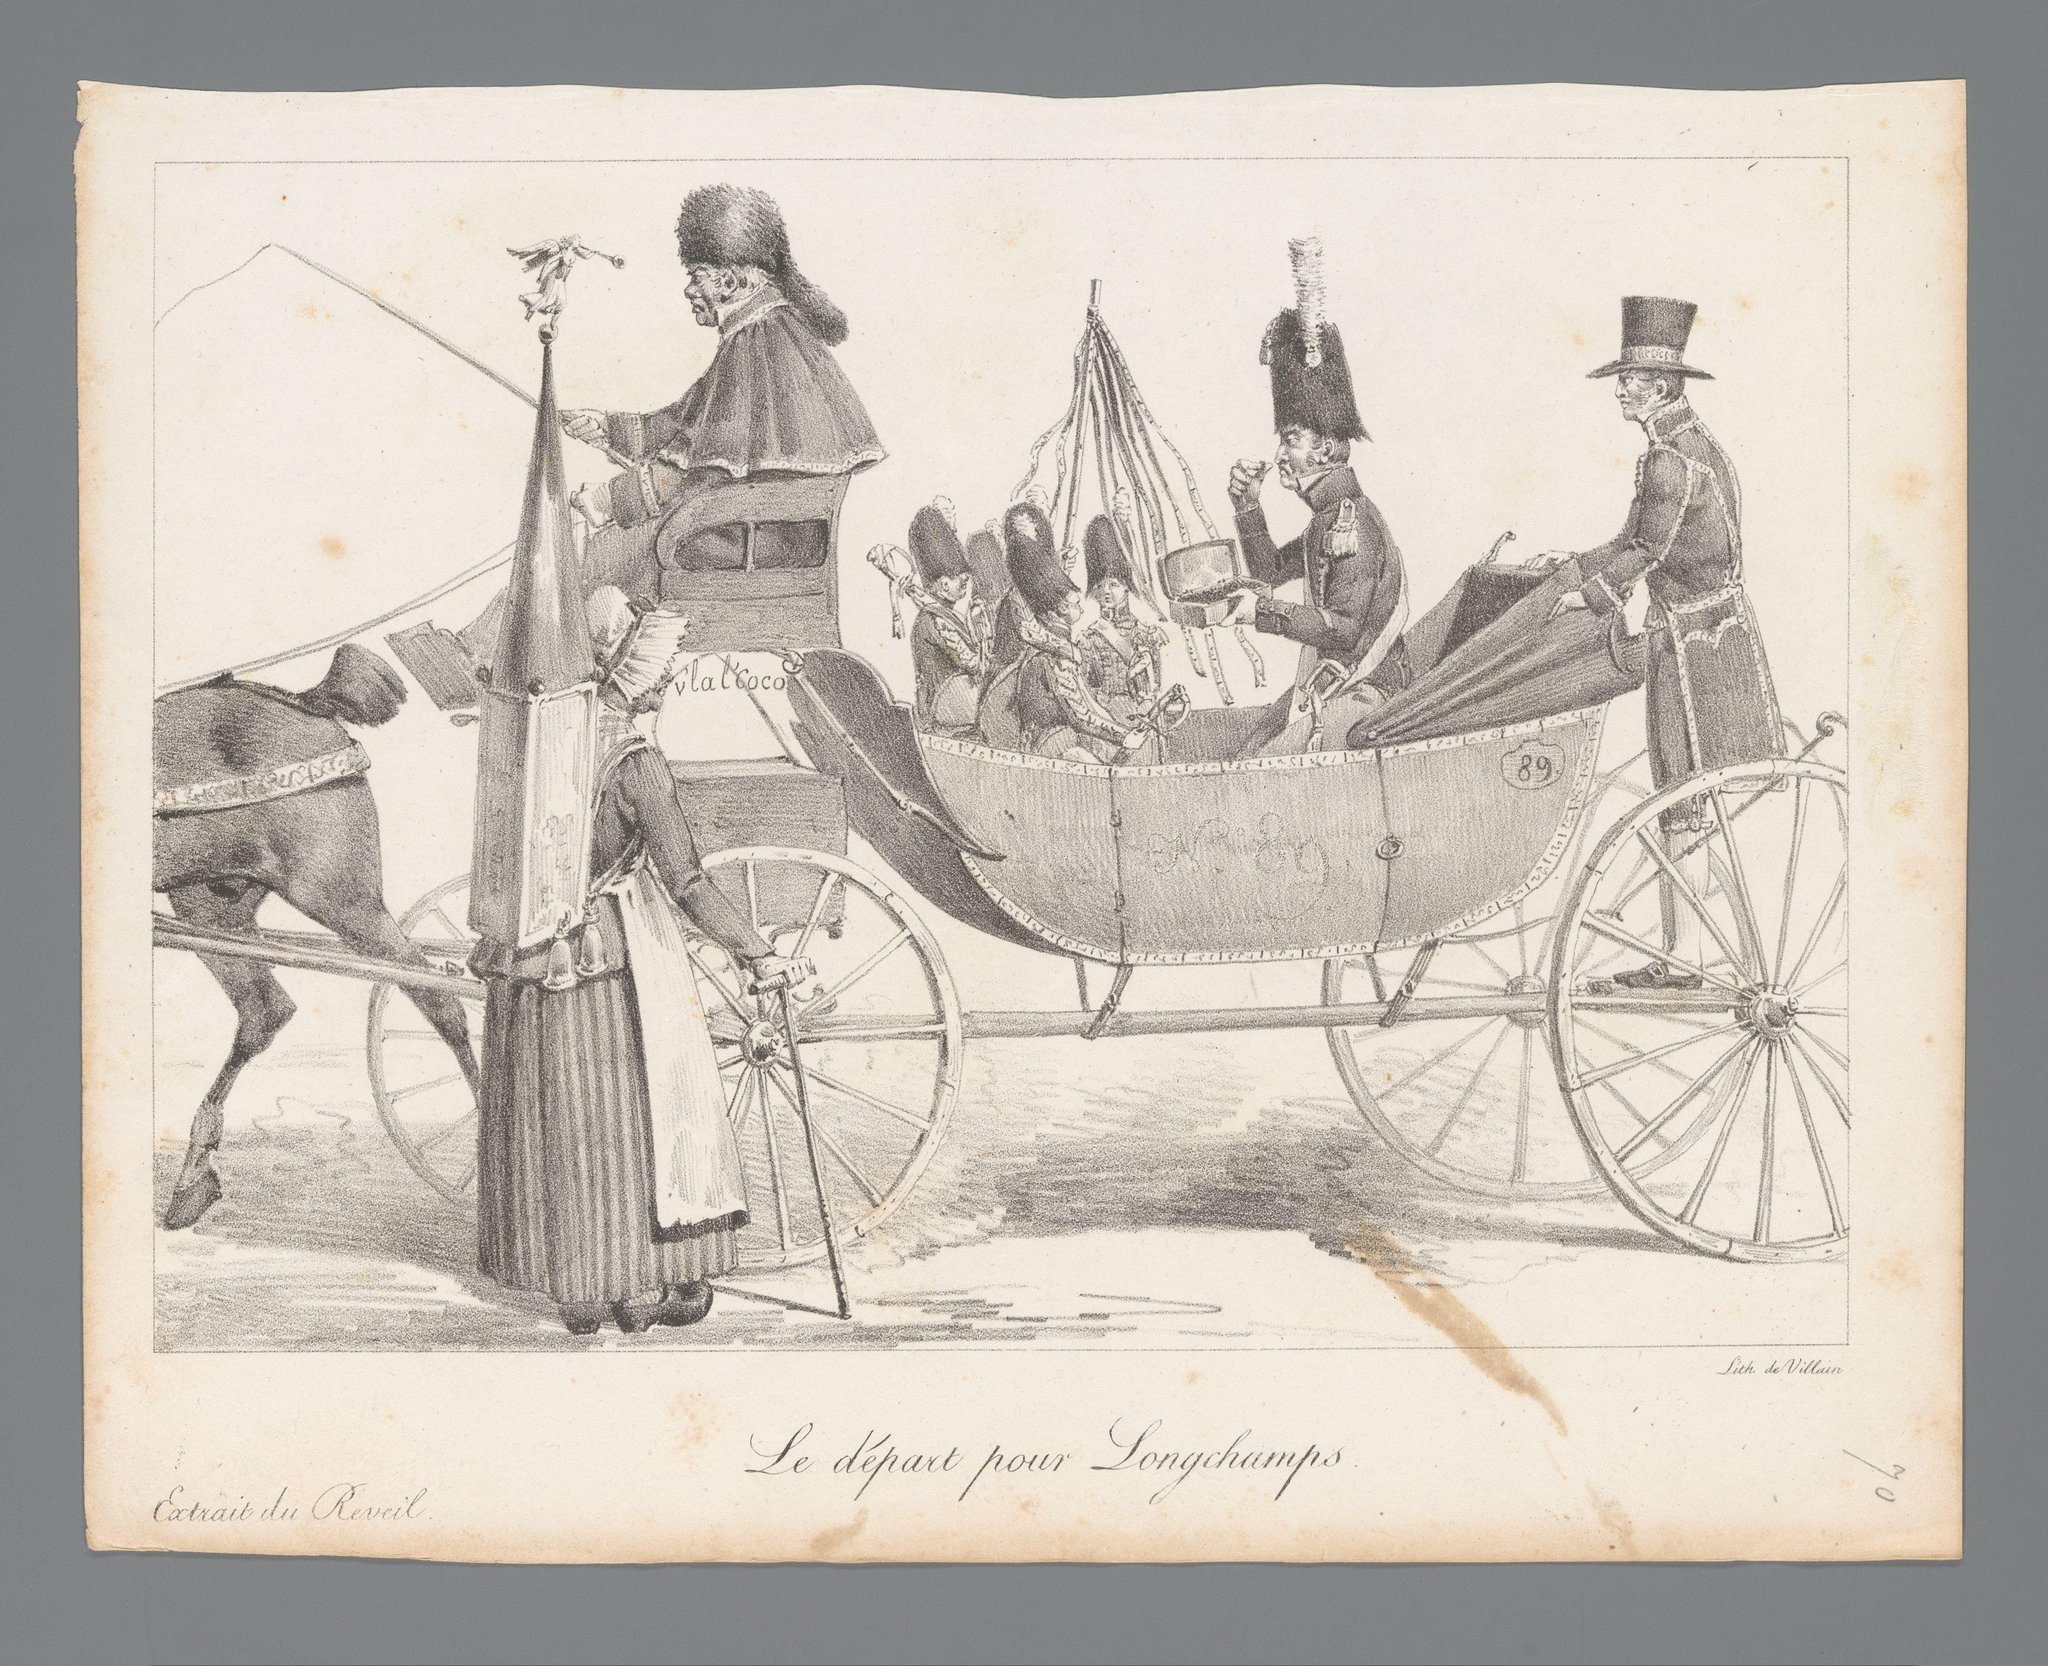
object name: print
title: Koets met militairen passeert omstanders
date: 1823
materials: paper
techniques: lithograph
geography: paris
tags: animal traction, animal-drawn vehicle (carriage etc.), warfare; military affairs (+ land forces)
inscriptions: collector's mark: Lugt 2228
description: Prent uit: Le Réveil, journal des sciences, de la littérature, des moeurs, théâtres et beaux-arts (1823), nr. 242, 30 maart 1823.